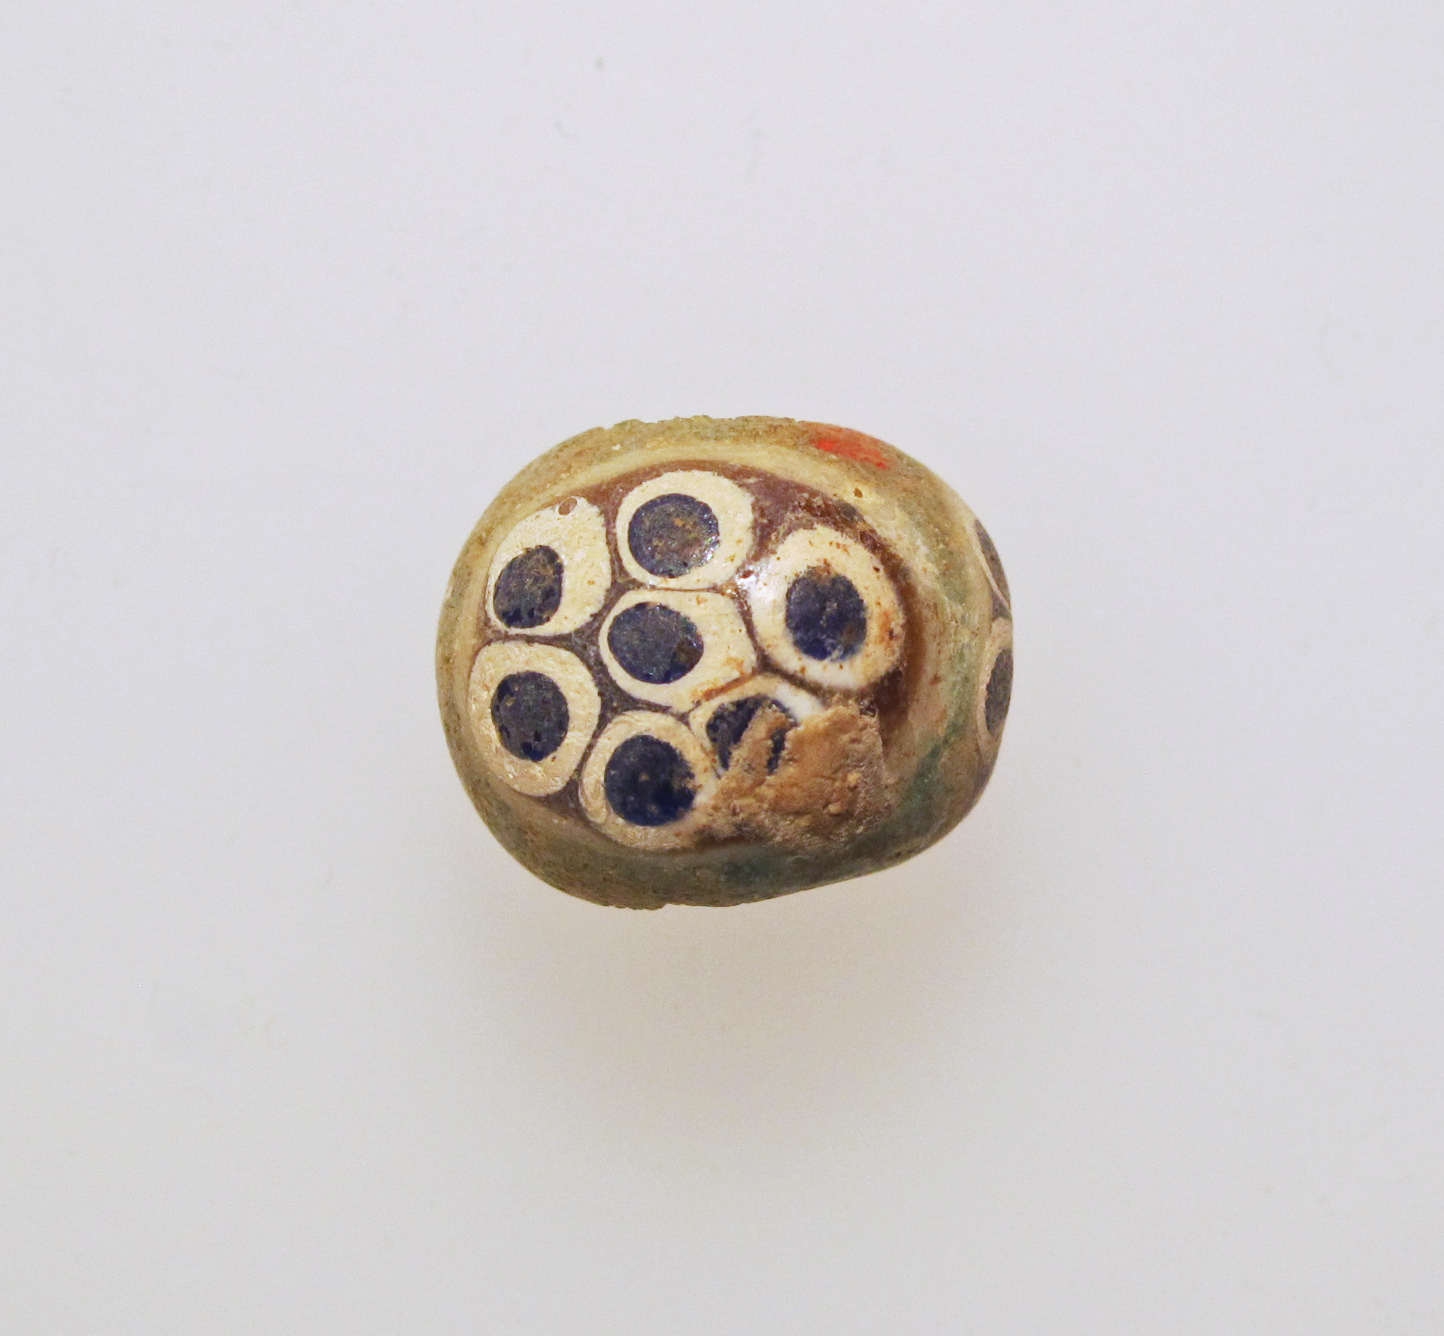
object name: bead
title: Glass compound eye bead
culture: greek, eastern mediterranean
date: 400-301 BCE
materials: glass